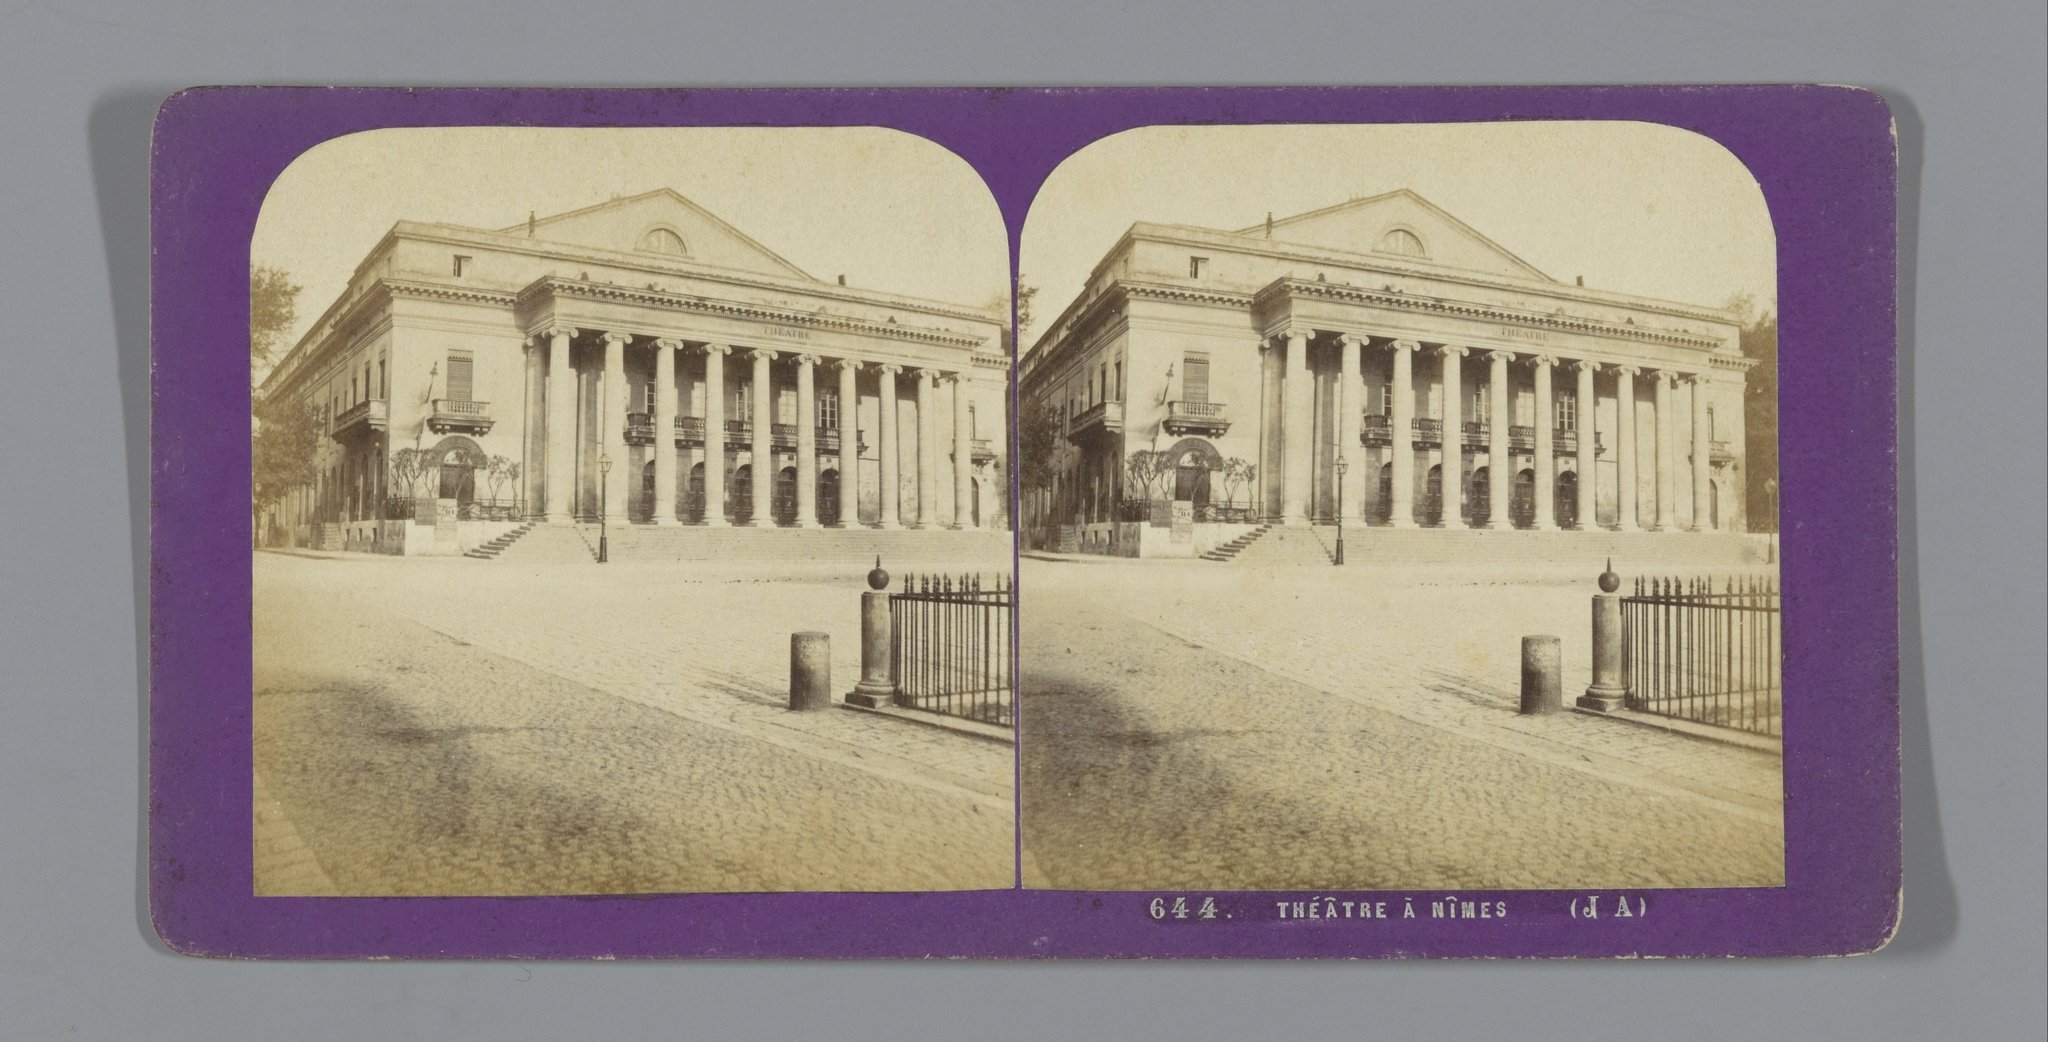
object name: stereograph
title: Exterieur van het theater van Nîmes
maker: jean andrieu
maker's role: fotograaf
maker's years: 1816-1872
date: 1862-1876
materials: cardboard, photographic support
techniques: albumen print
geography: nîmes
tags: theatre (building)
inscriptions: number: ‘644.’